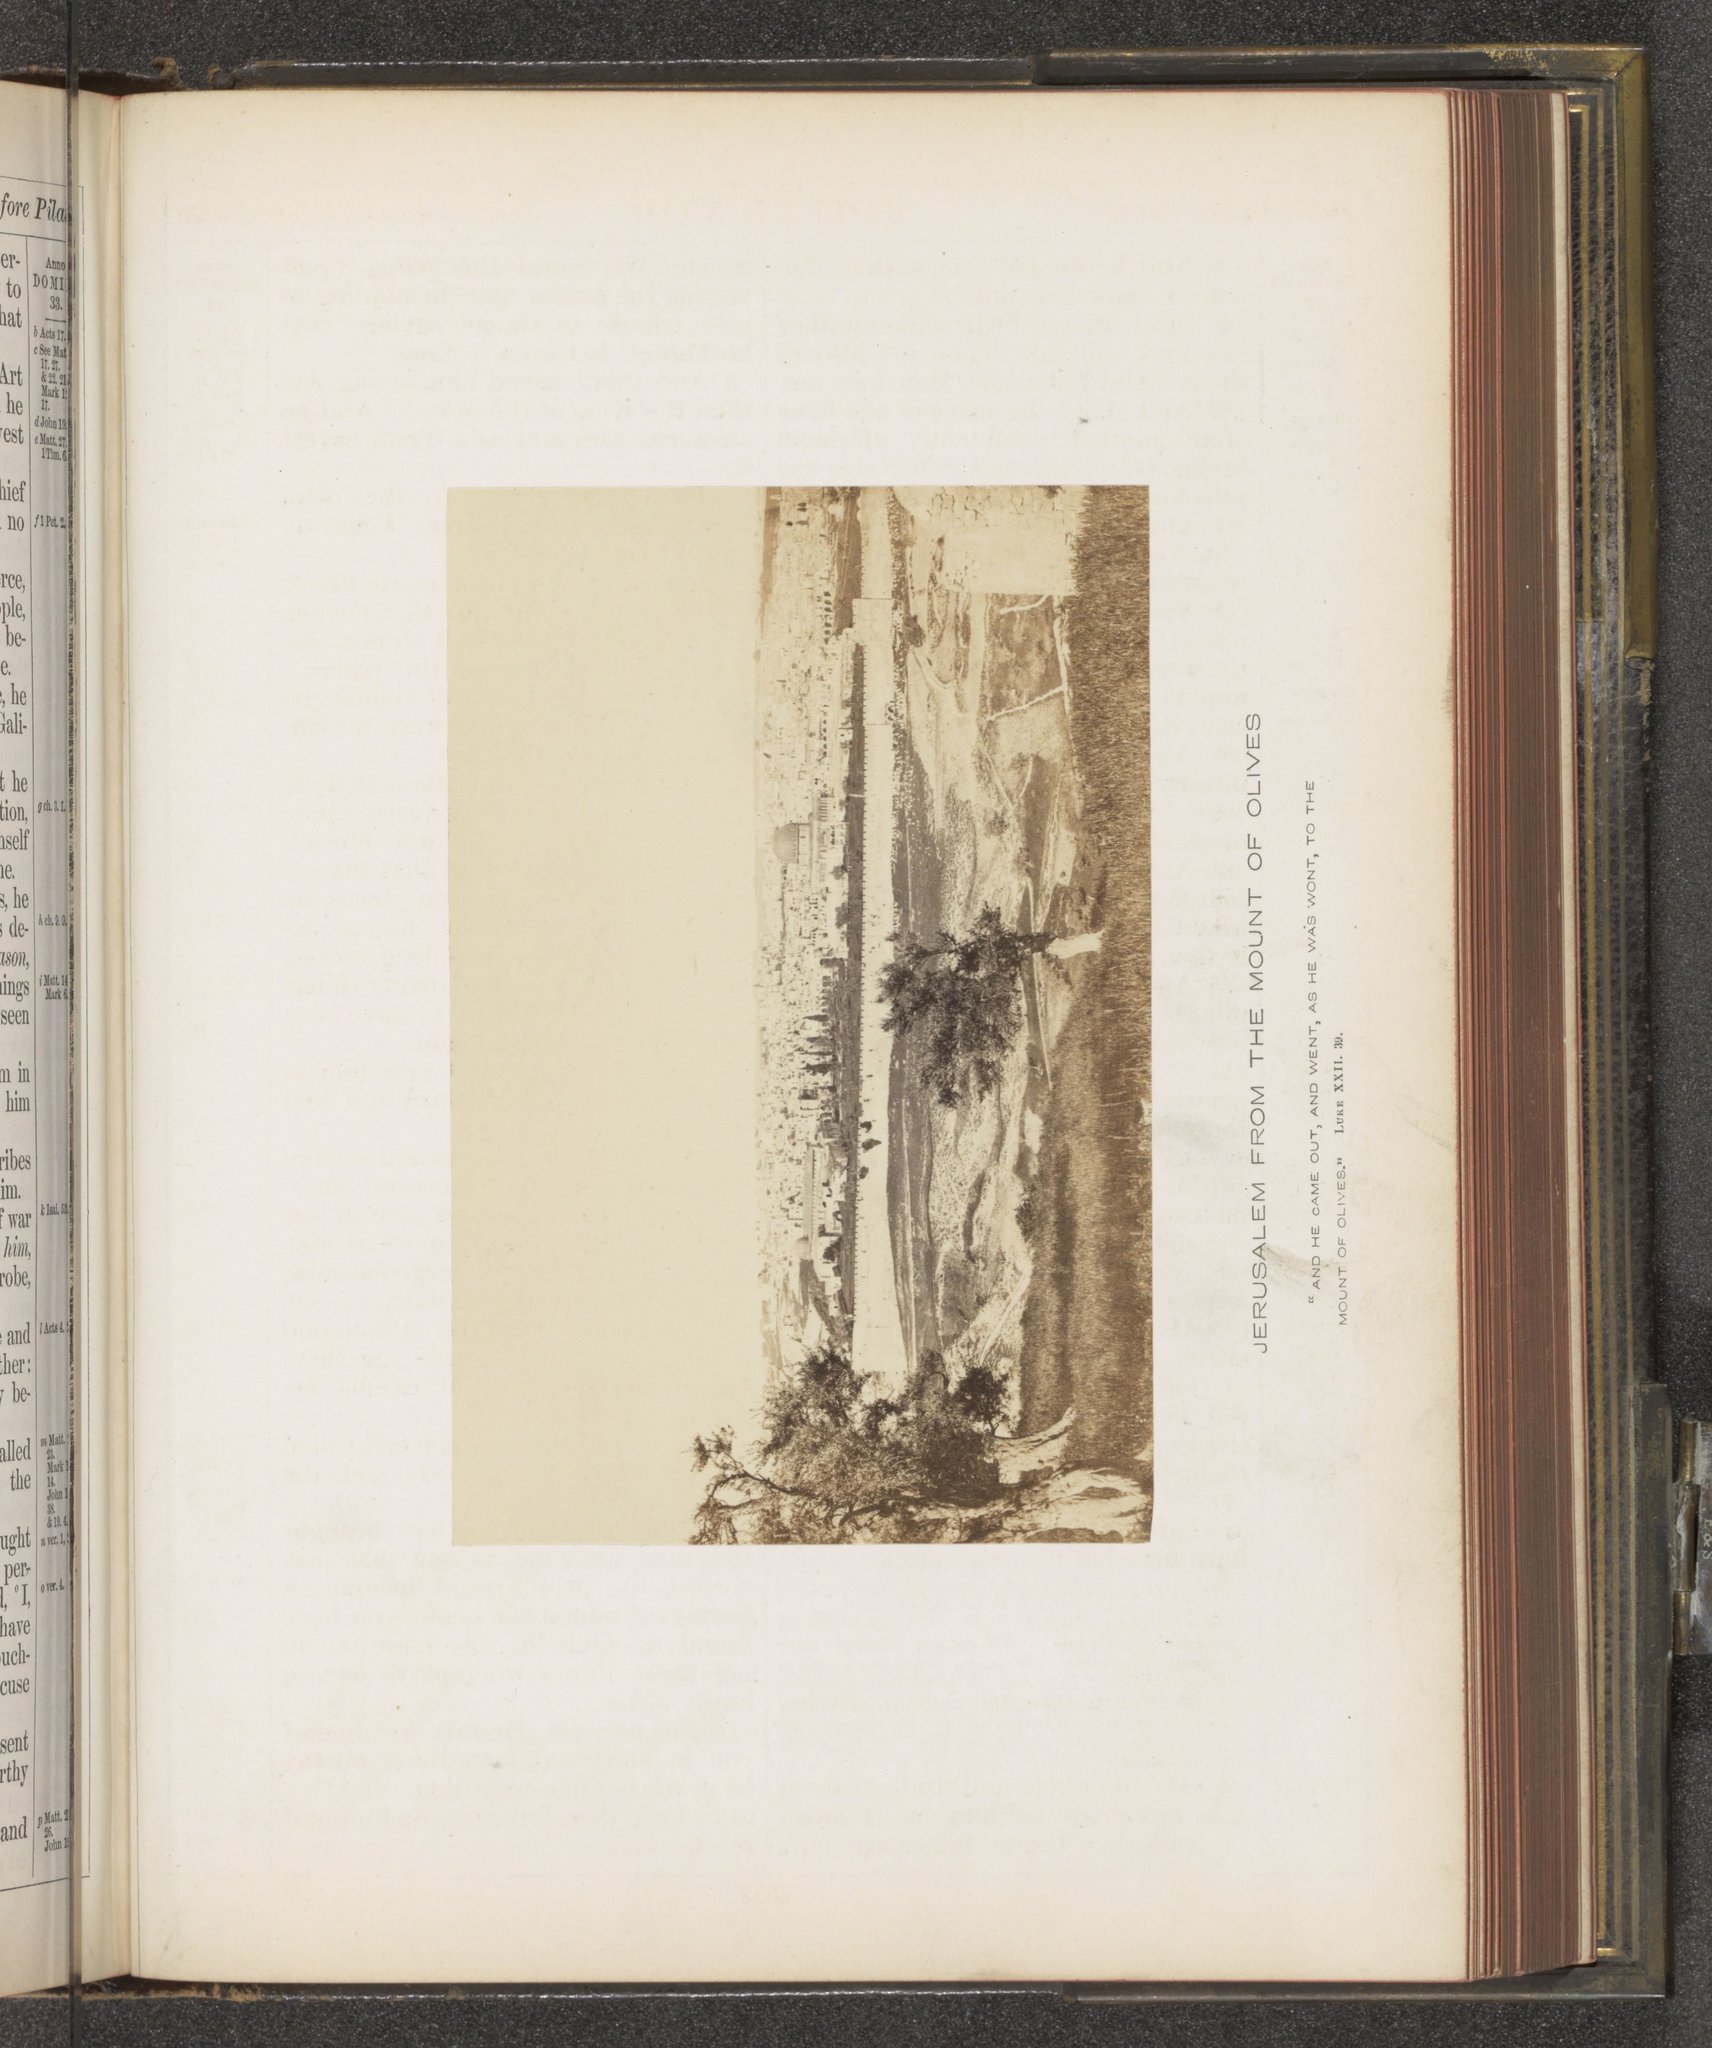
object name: page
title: Jerusalem from the Mount of Olives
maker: francis frith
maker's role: publisher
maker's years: 1822-1898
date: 1850-1865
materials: photographic support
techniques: albumen print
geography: jerusalem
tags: landscapes, city-view in general; 'veduta'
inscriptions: inscription: ‘"And he came out, and went, as he was wont, to the Mount of Olives." Luke XXII. 39.’